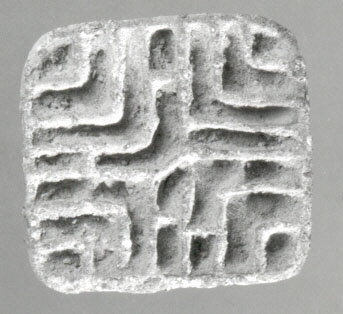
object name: stamp seal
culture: bactria-margiana archaeological complex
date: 2333-1668 BCE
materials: copper alloy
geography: bactria-margiana